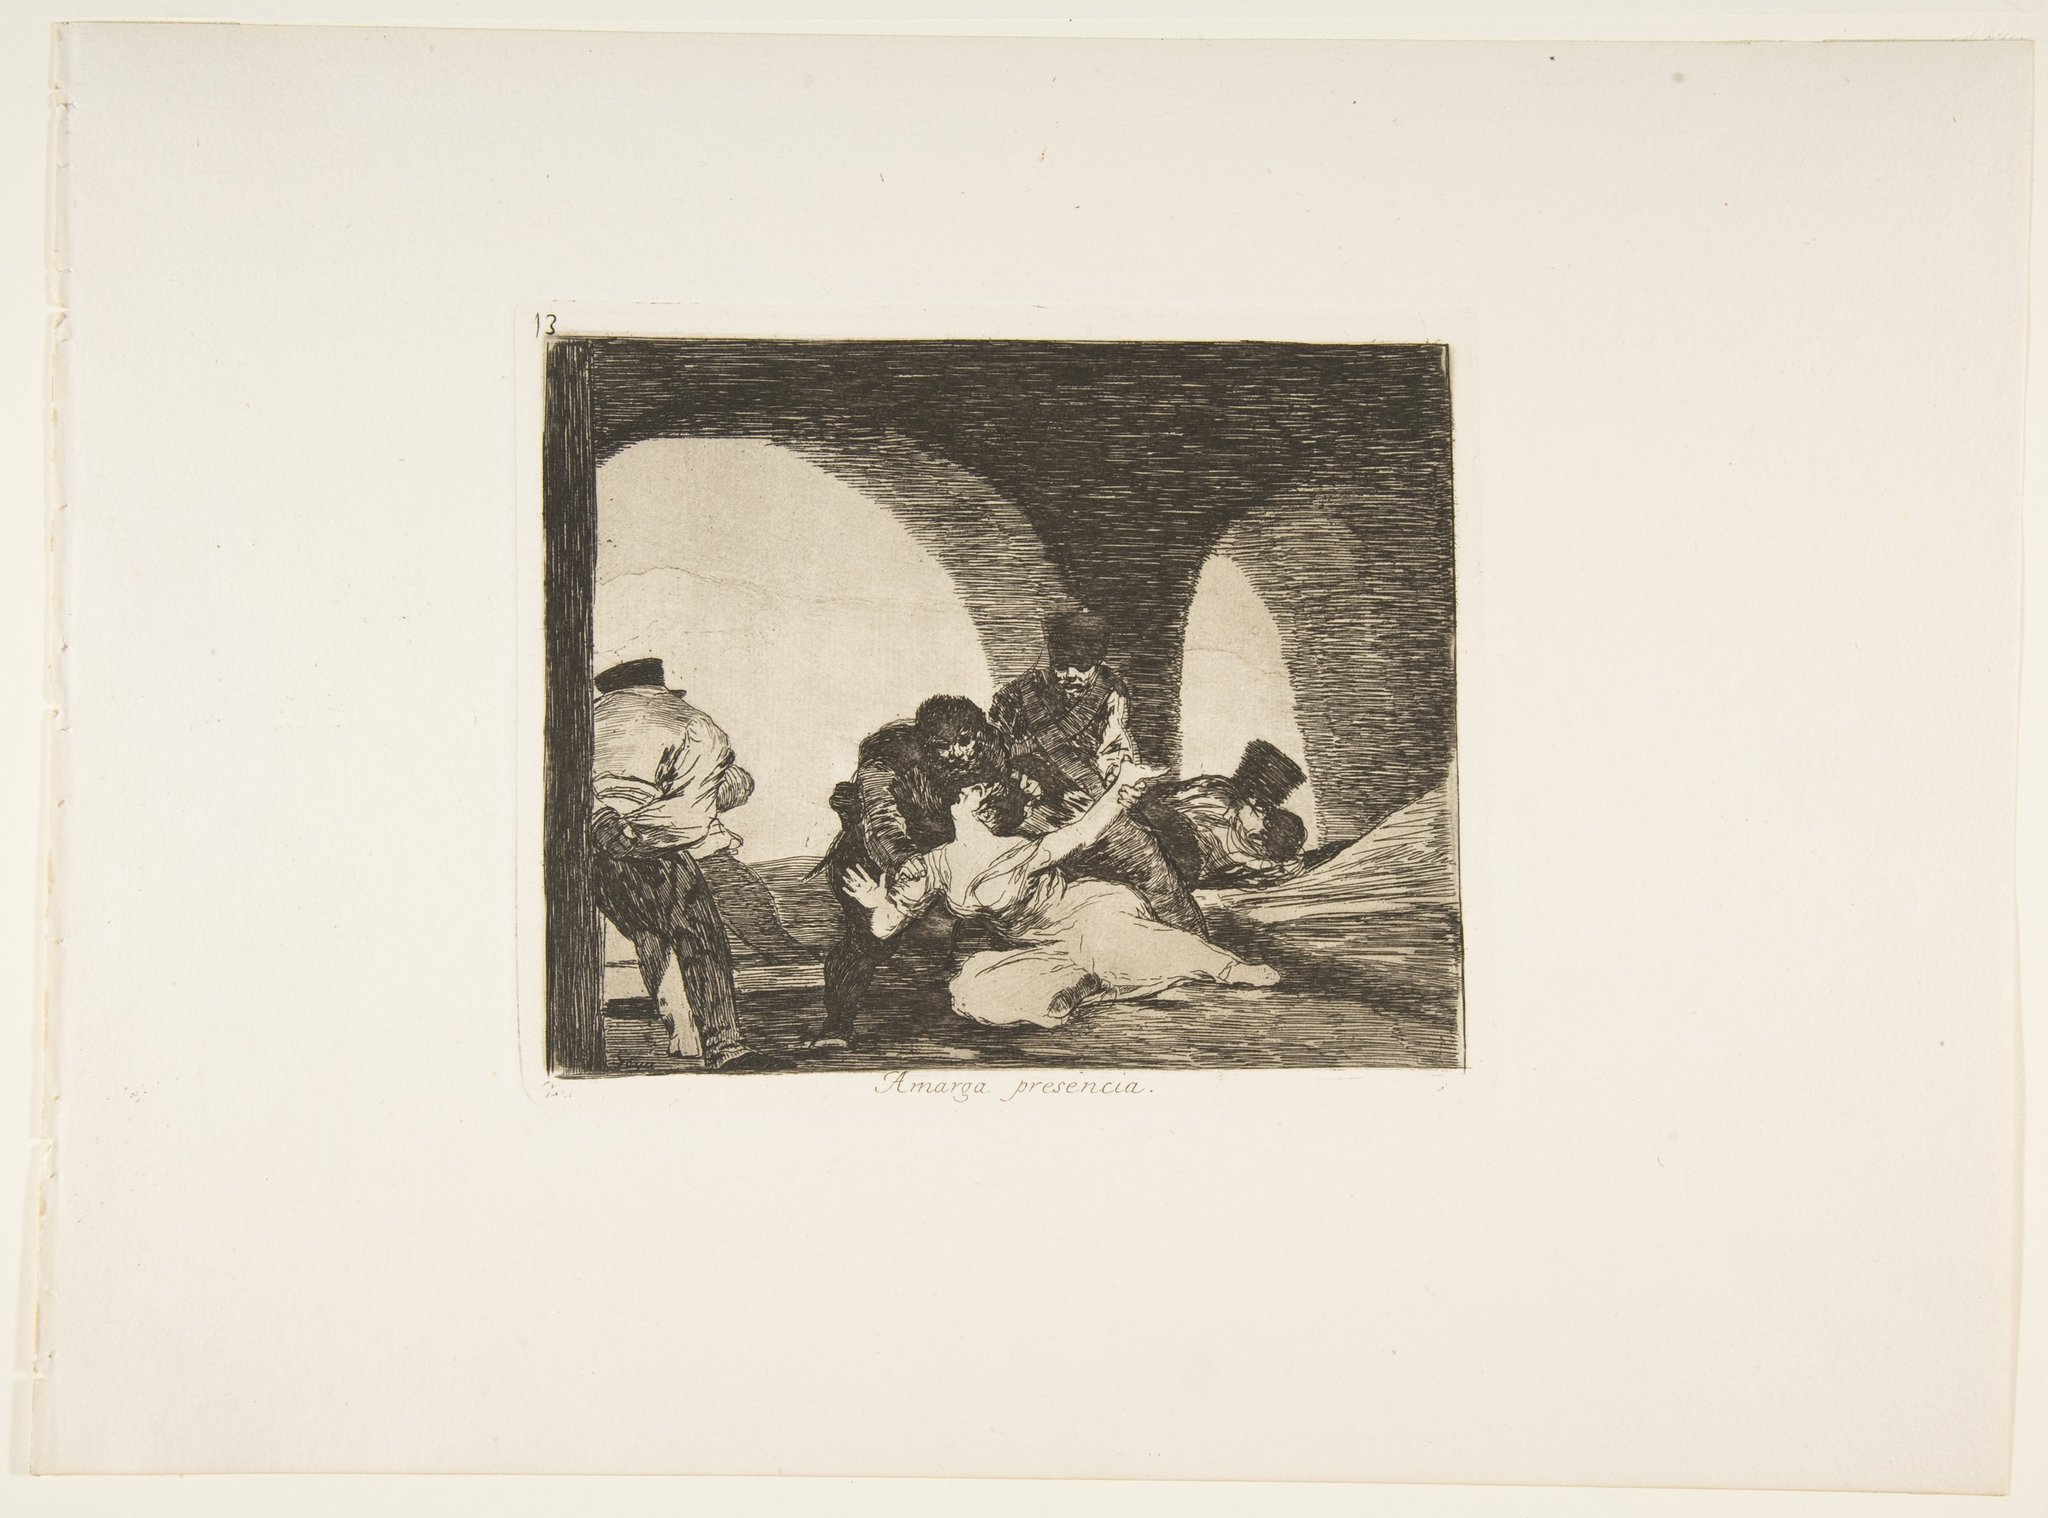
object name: print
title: Plate 13 from "The Disasters of War" (Los Desastres de la Guerra): 'Bitter to be Present' (Amarga presencia)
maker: goya (francisco de goya y lucientes)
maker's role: artist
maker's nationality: spanish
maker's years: 1746-1828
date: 1810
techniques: engraving, drypoint, etching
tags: men,women